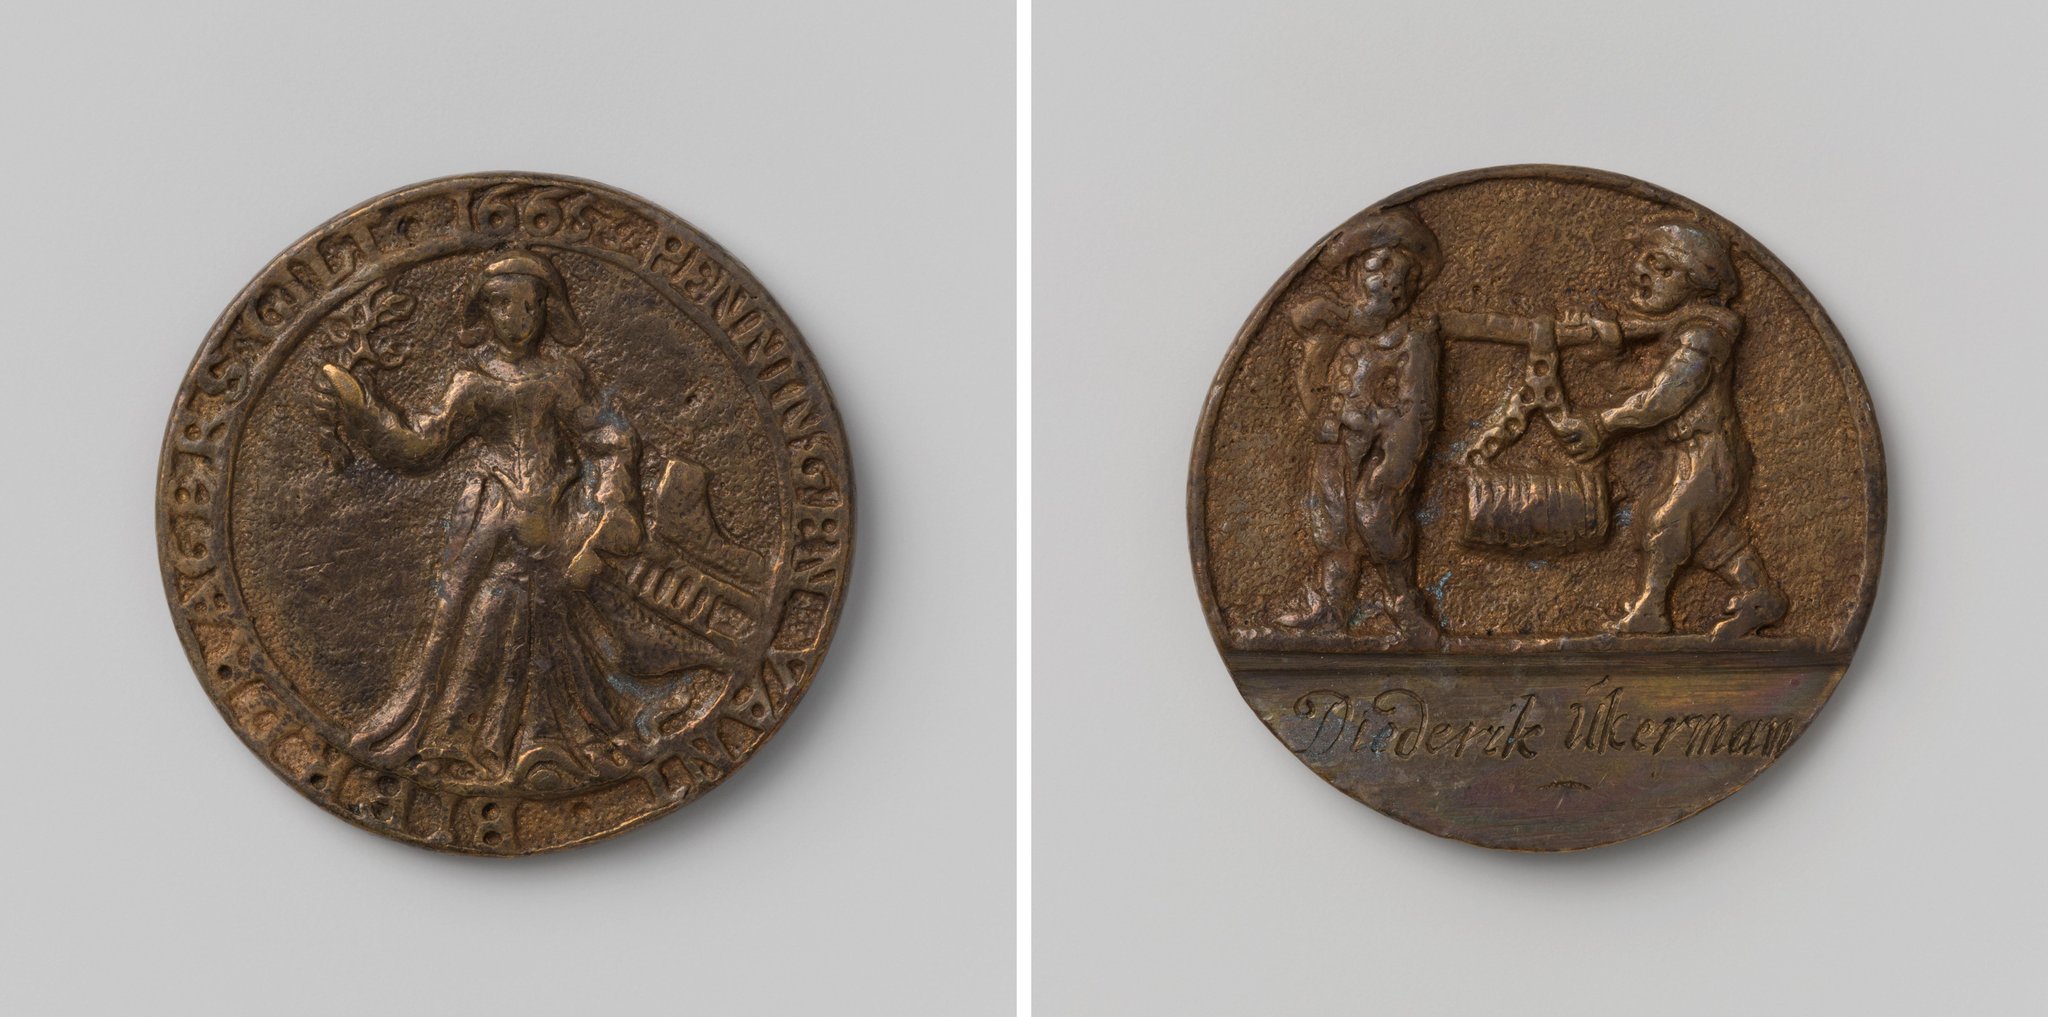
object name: medal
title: Bierdragersgilde van Amsterdam, gildepenning van Diederik Ukerman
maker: Anonymous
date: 1665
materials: brass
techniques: casting, engraving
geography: amsterdam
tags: amsterdam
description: Water and land transport. Beer porters, Amsterdam.